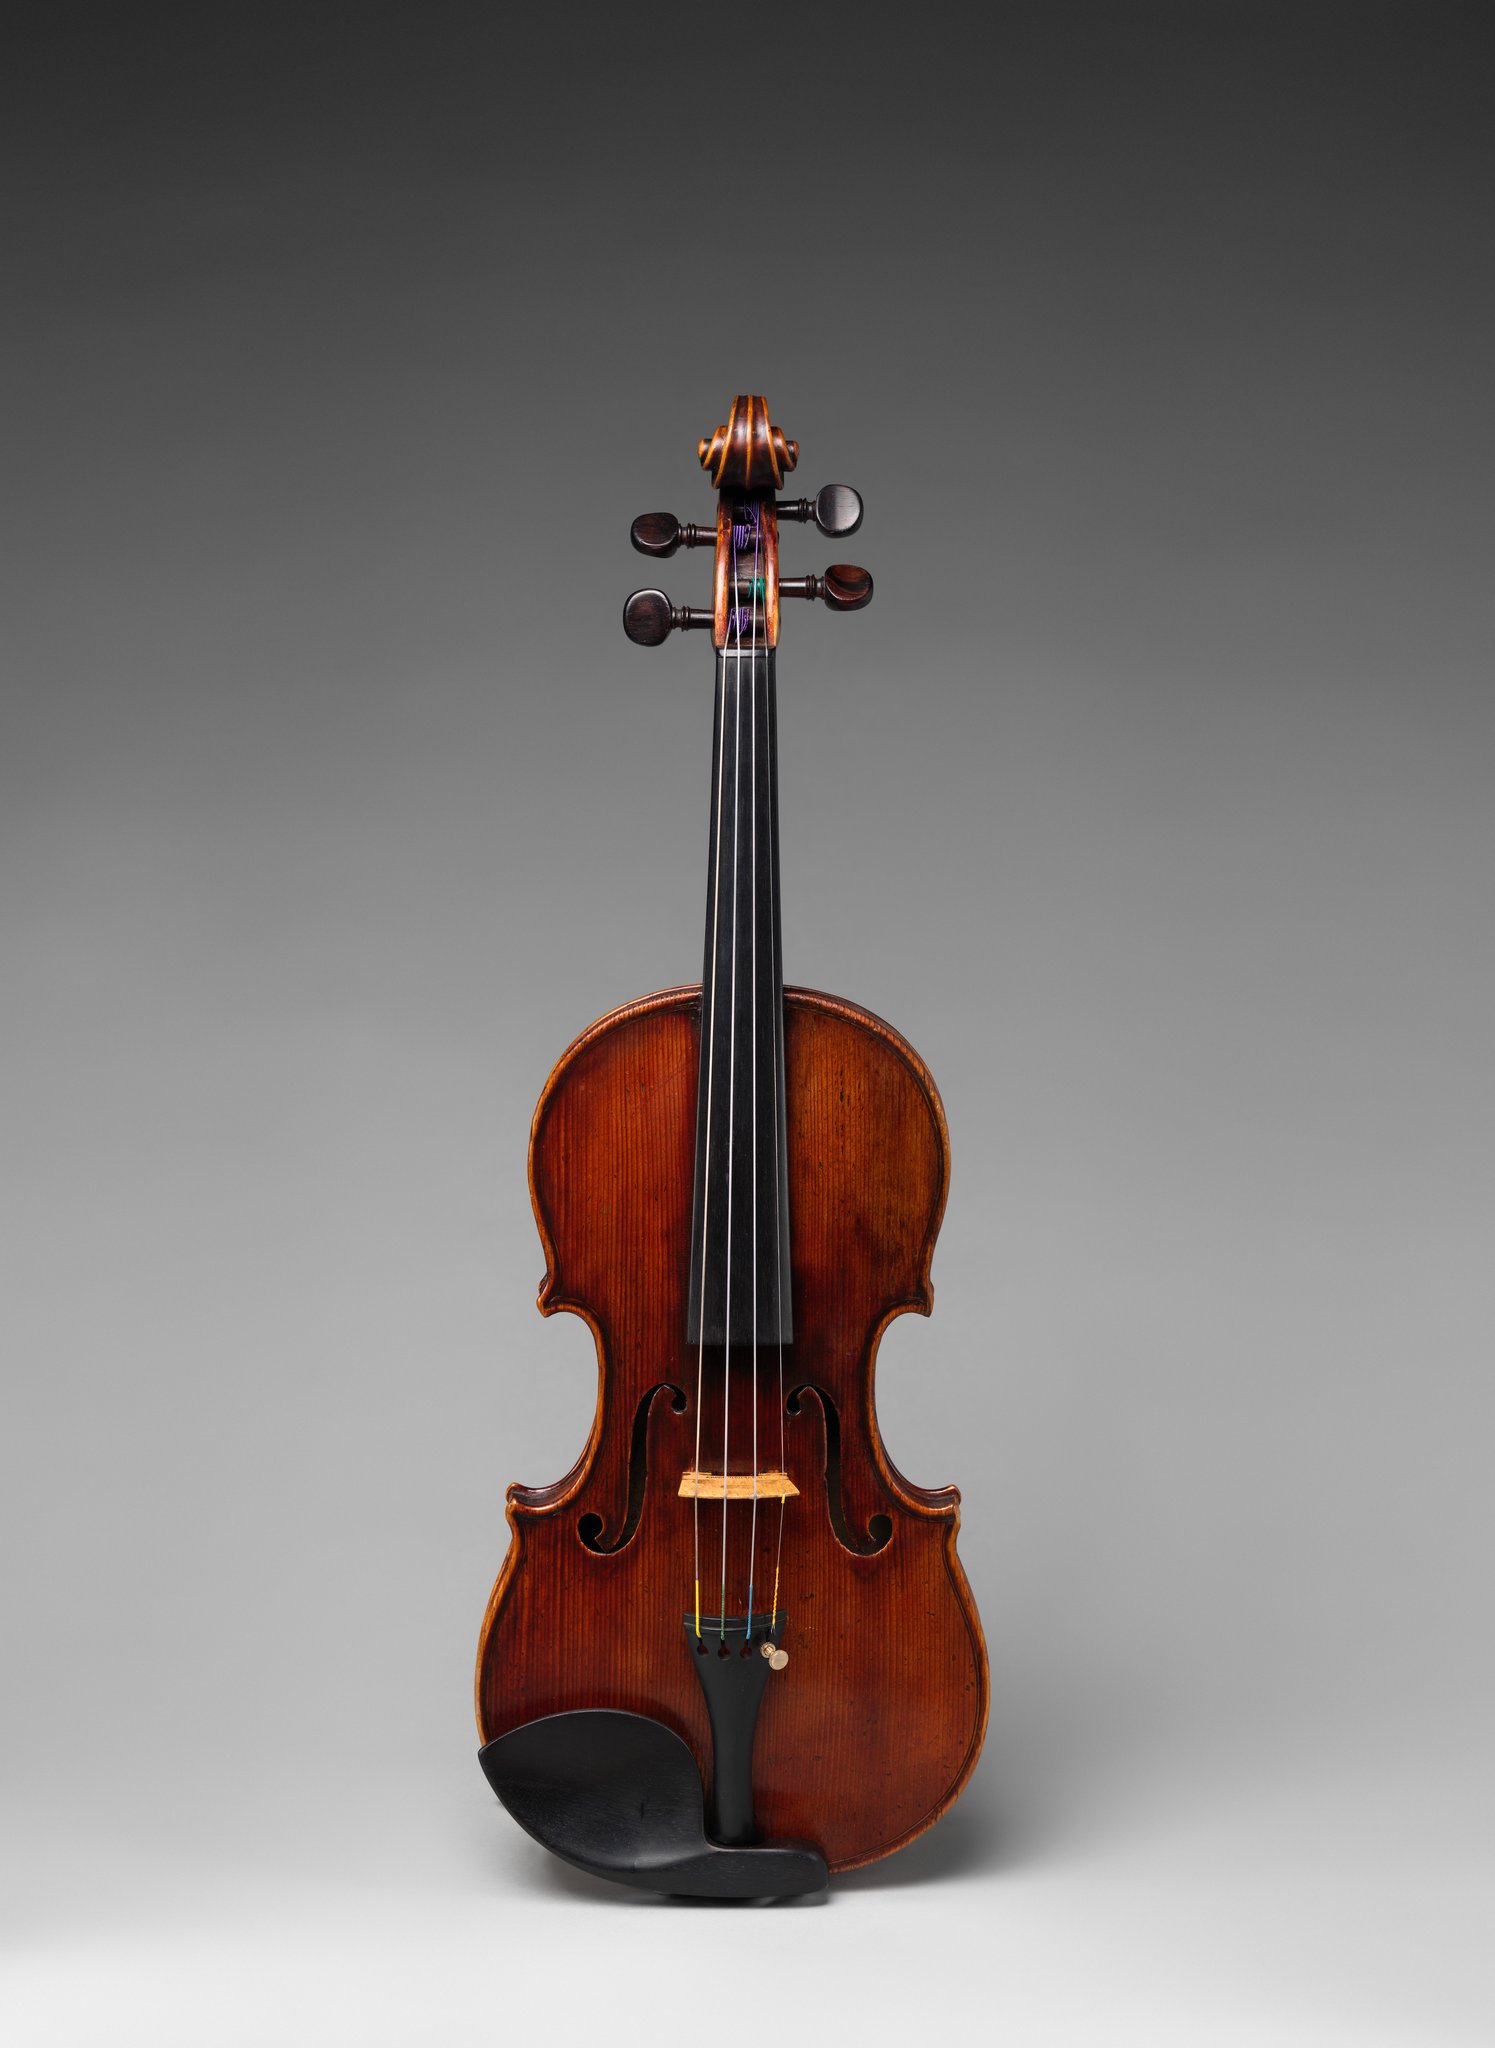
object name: violin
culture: french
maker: françois-louis pique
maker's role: maker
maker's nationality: french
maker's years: 1757-1822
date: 1803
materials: wood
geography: france